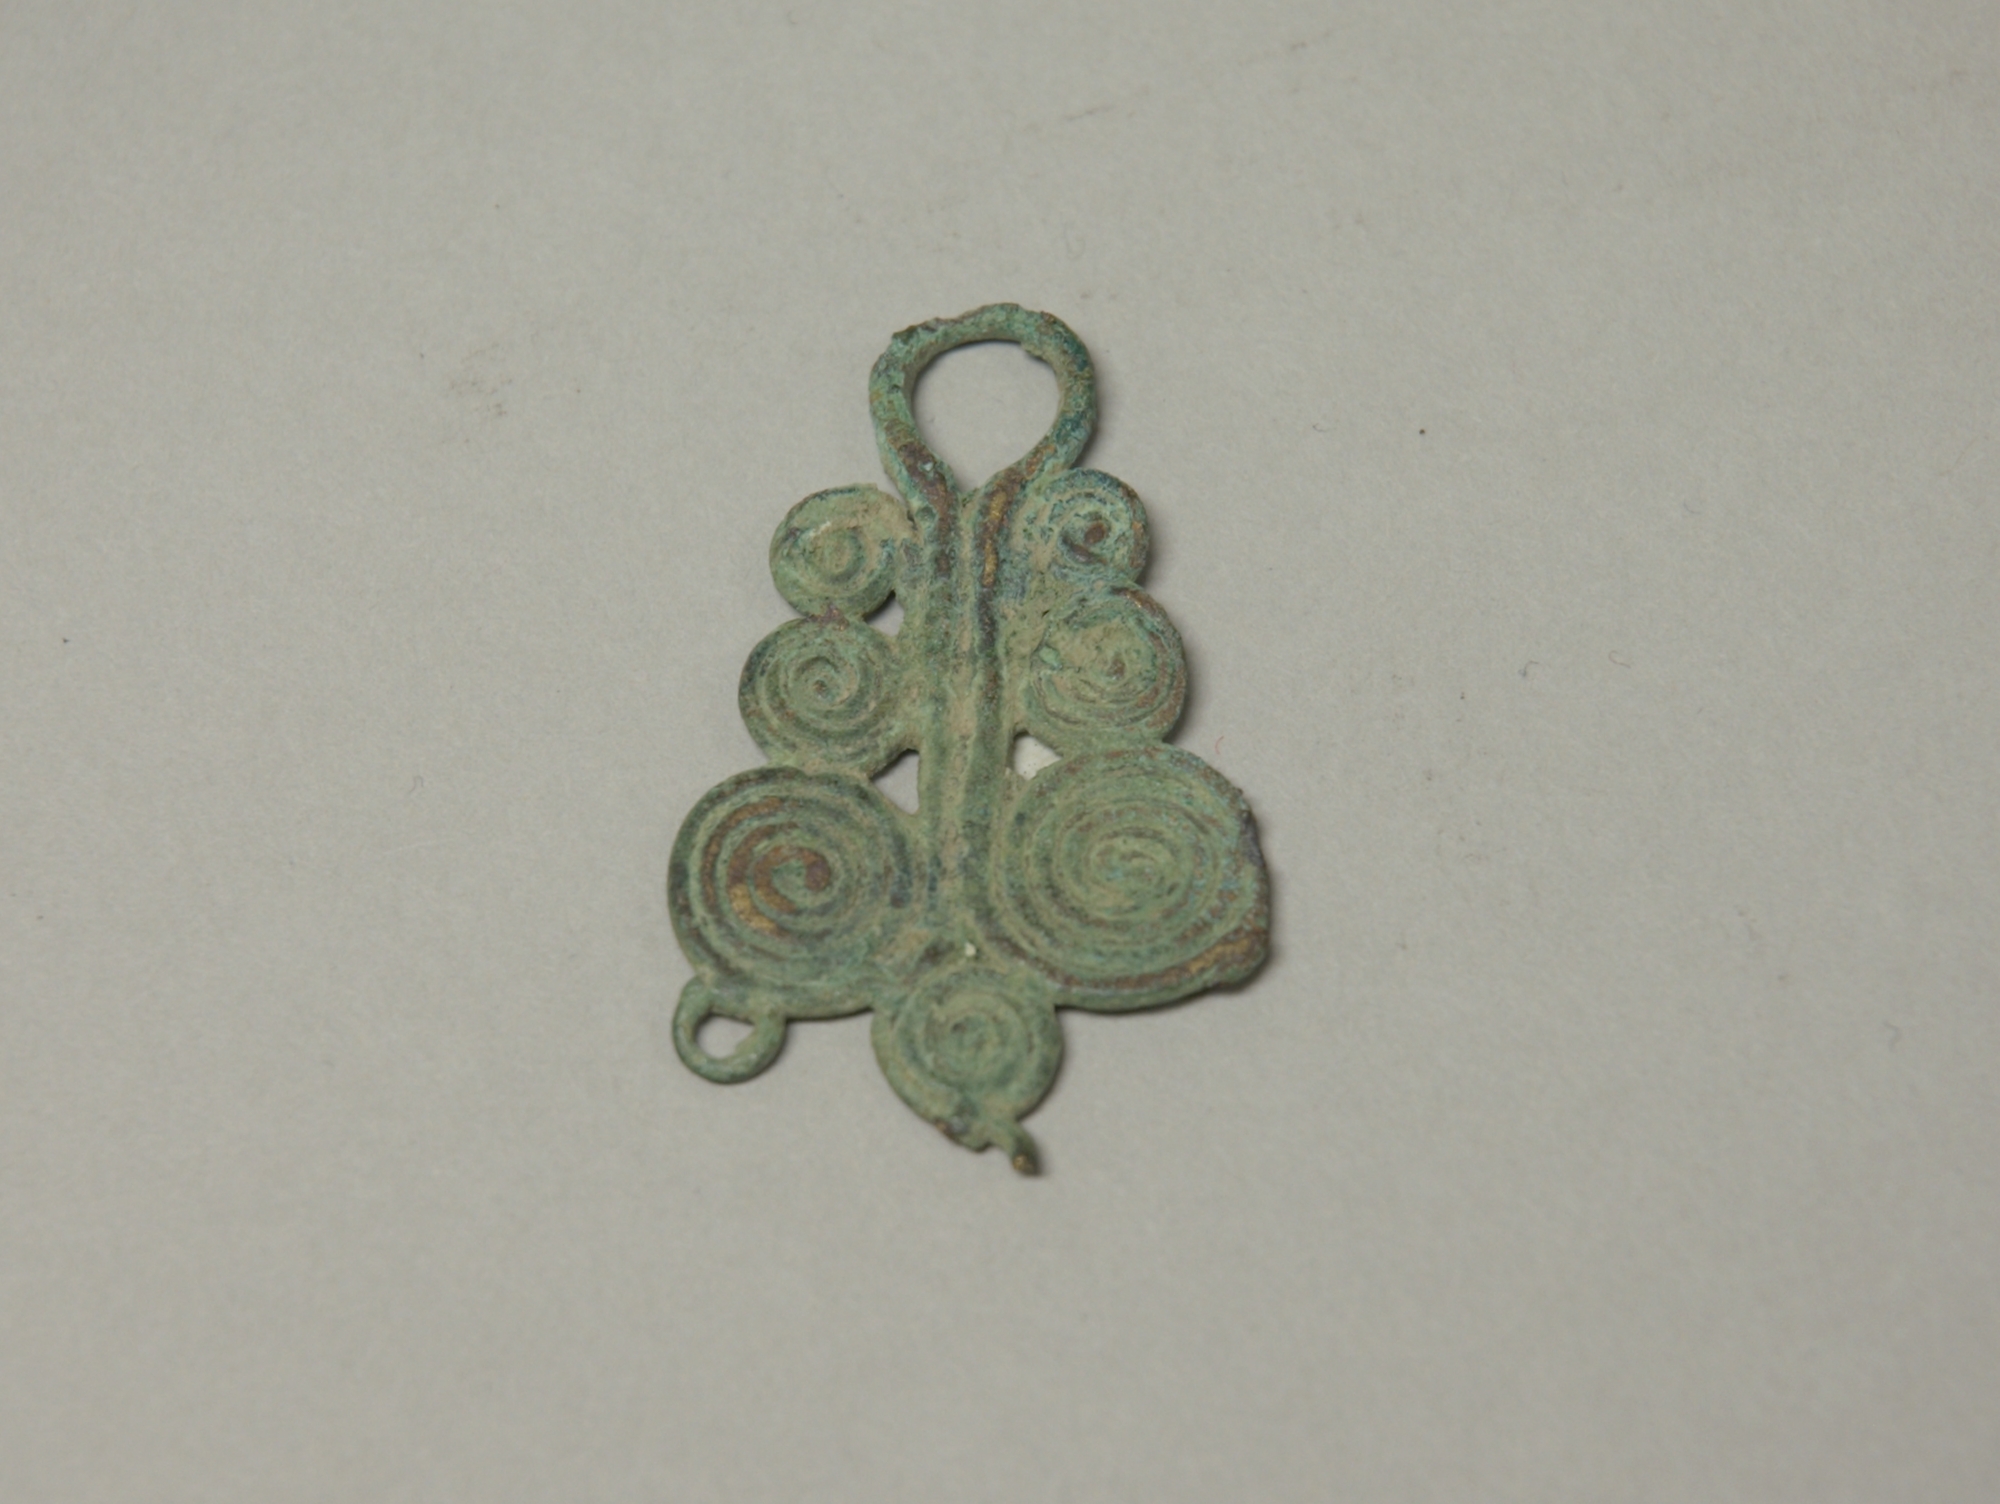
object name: pendant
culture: indonesian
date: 500 BCE-300 CE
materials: bronze